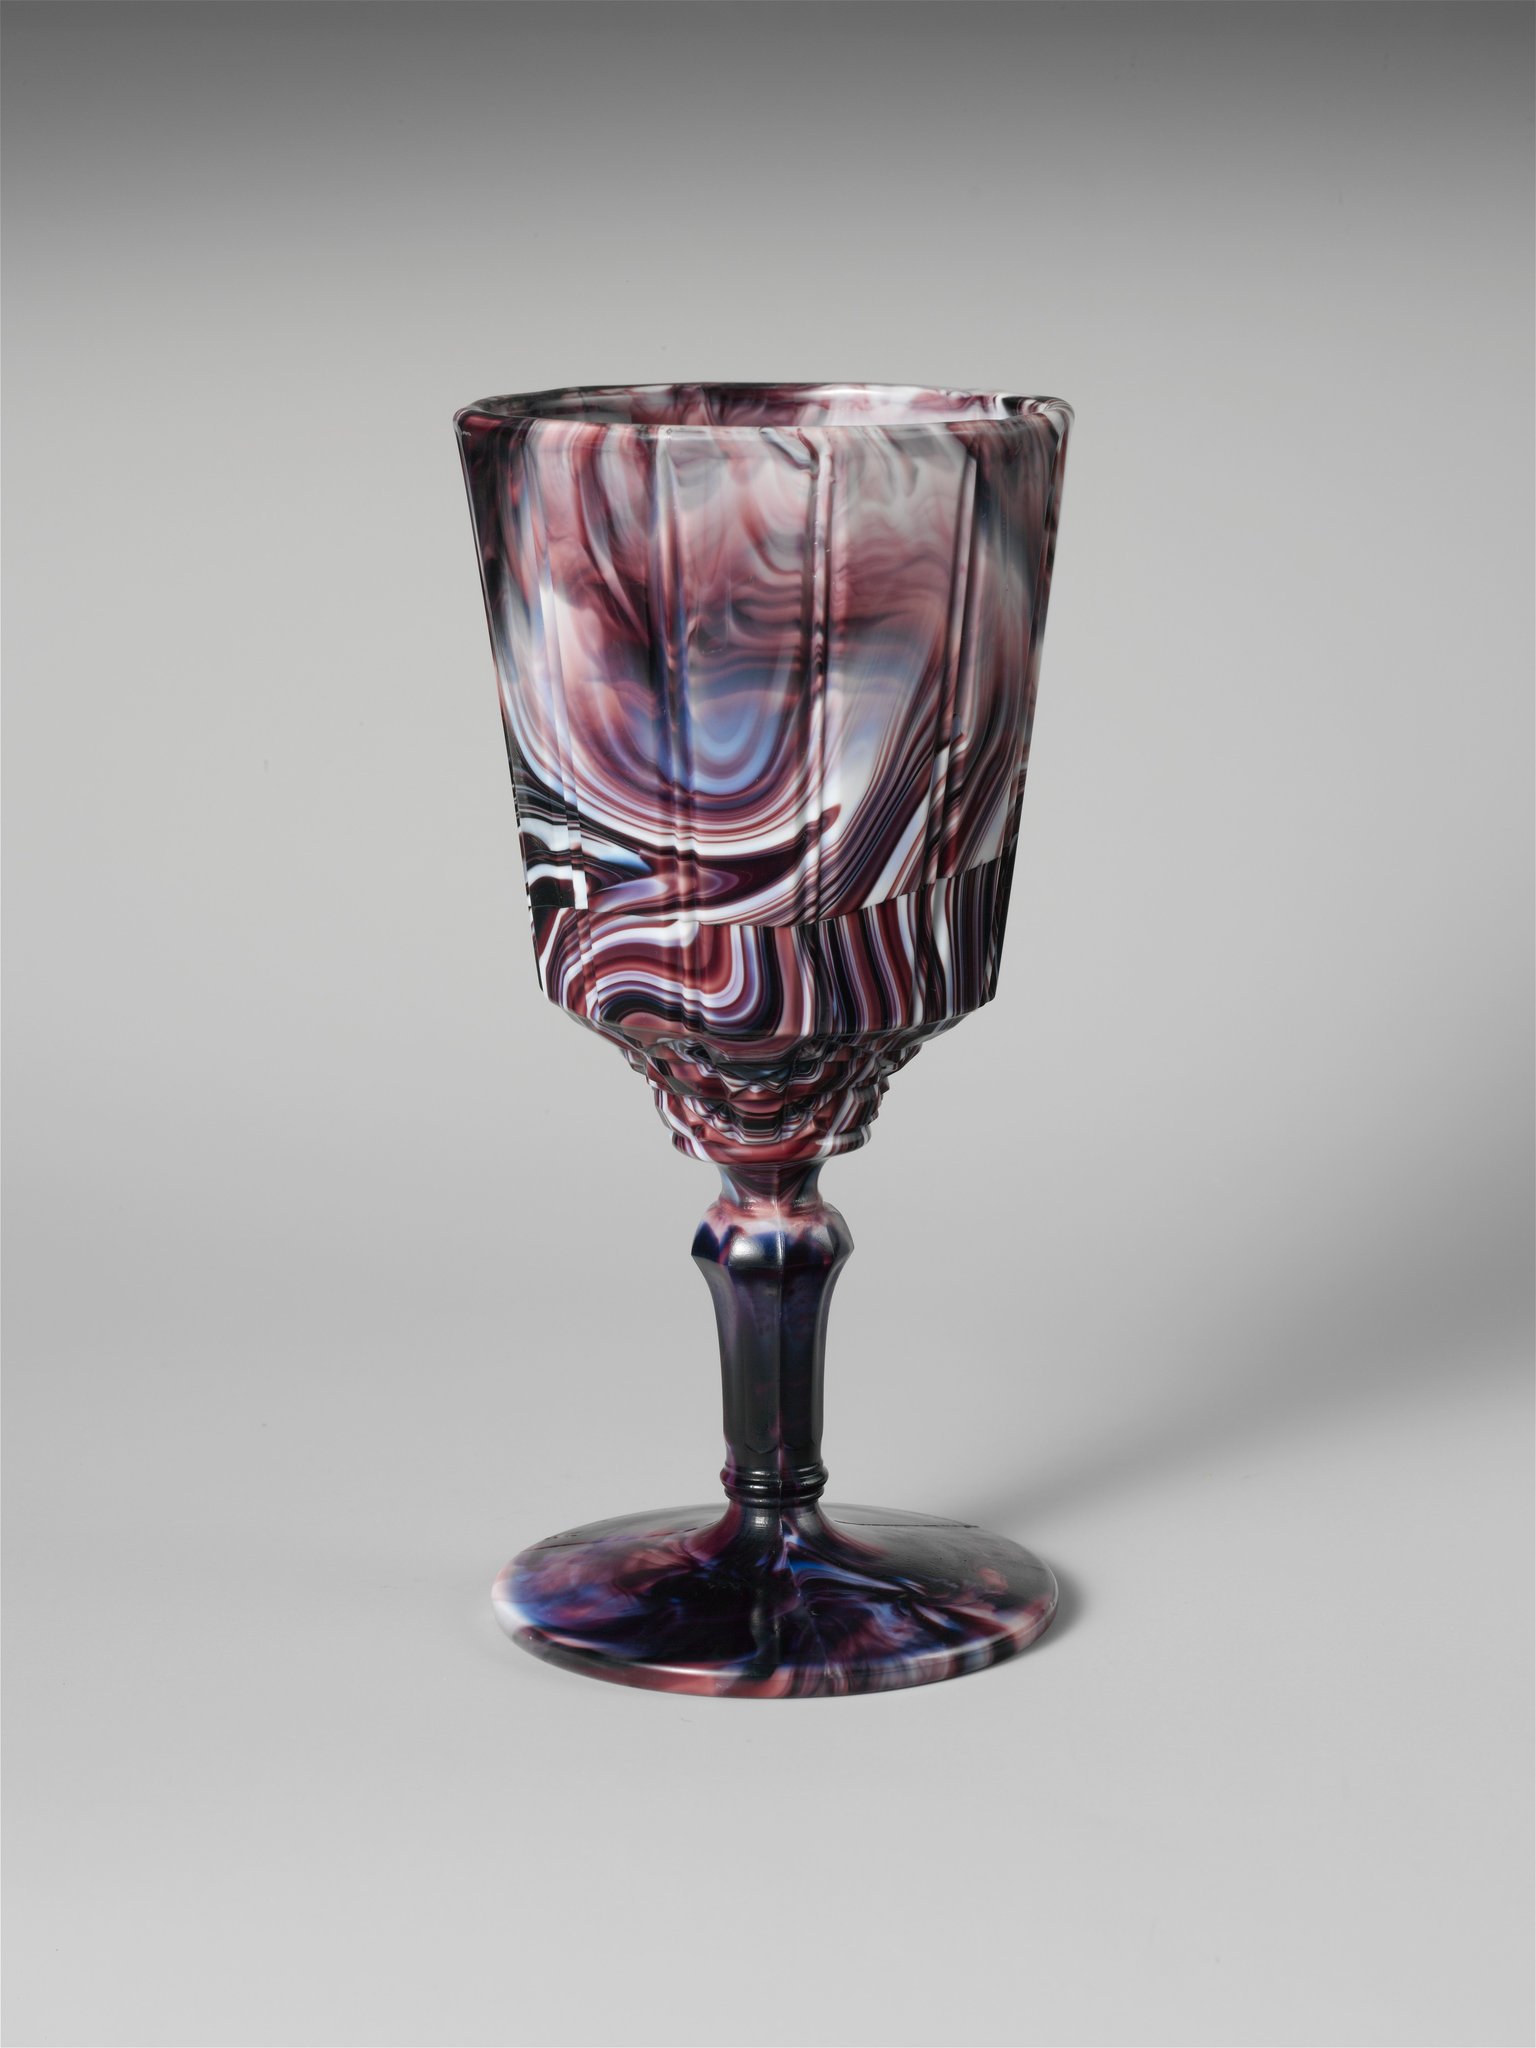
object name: goblet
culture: american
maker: challinor, taylor and company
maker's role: maker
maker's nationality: american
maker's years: 1866-1891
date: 1870-1890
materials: glass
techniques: pressed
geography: united states